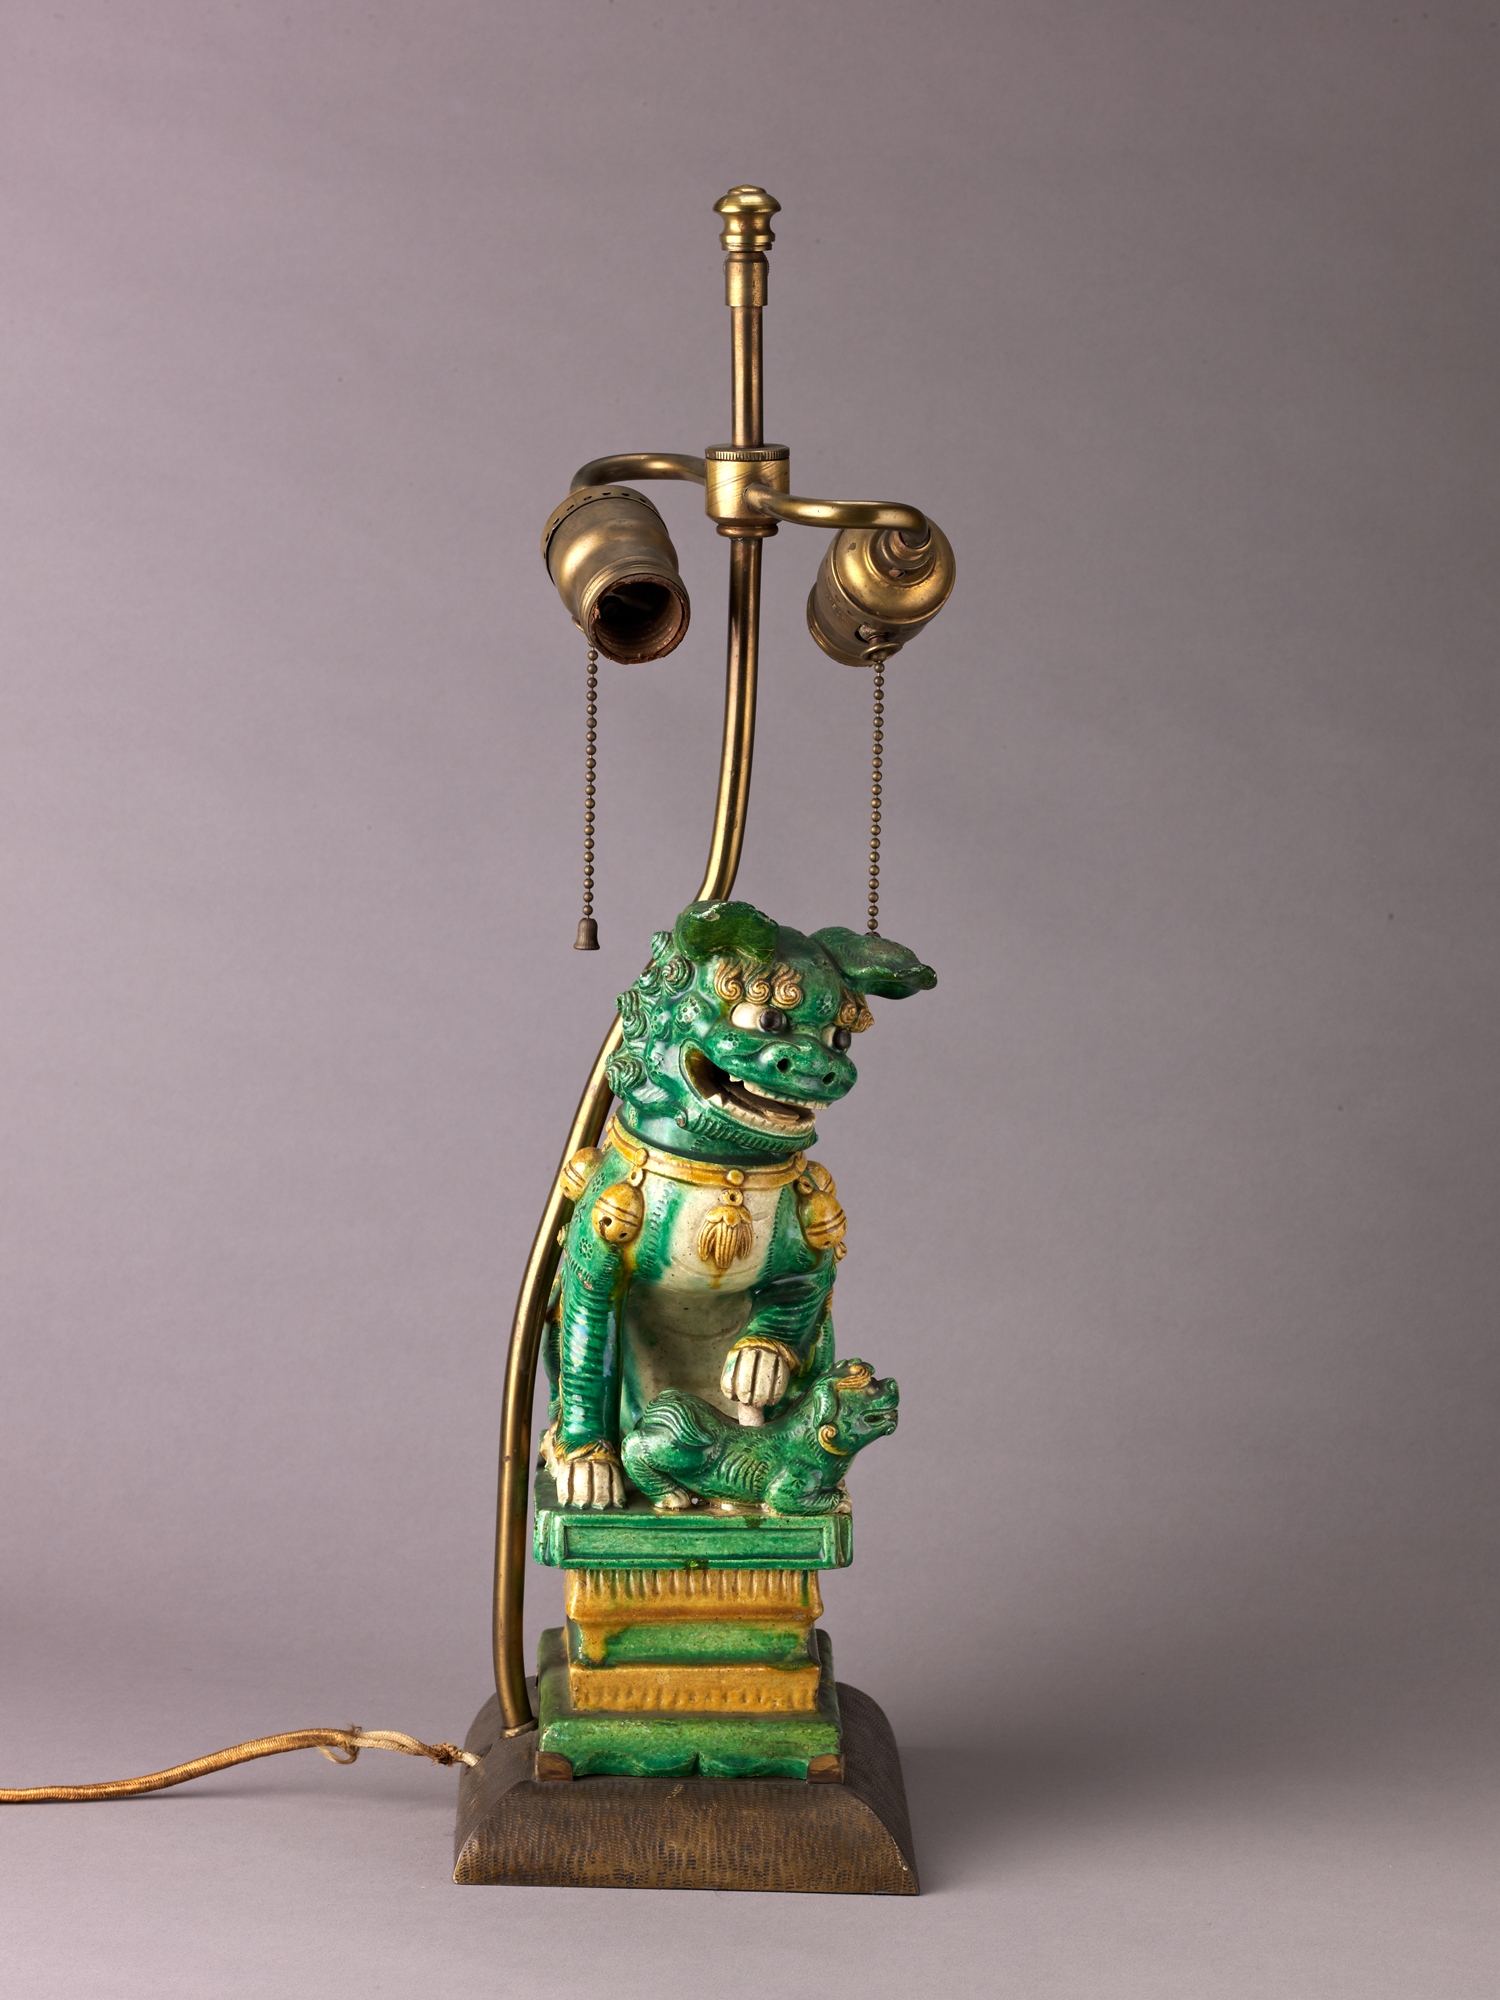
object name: lion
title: Figure of lion mounted as lamp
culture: chinese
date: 1801-1900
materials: glaze, porcelain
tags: lions